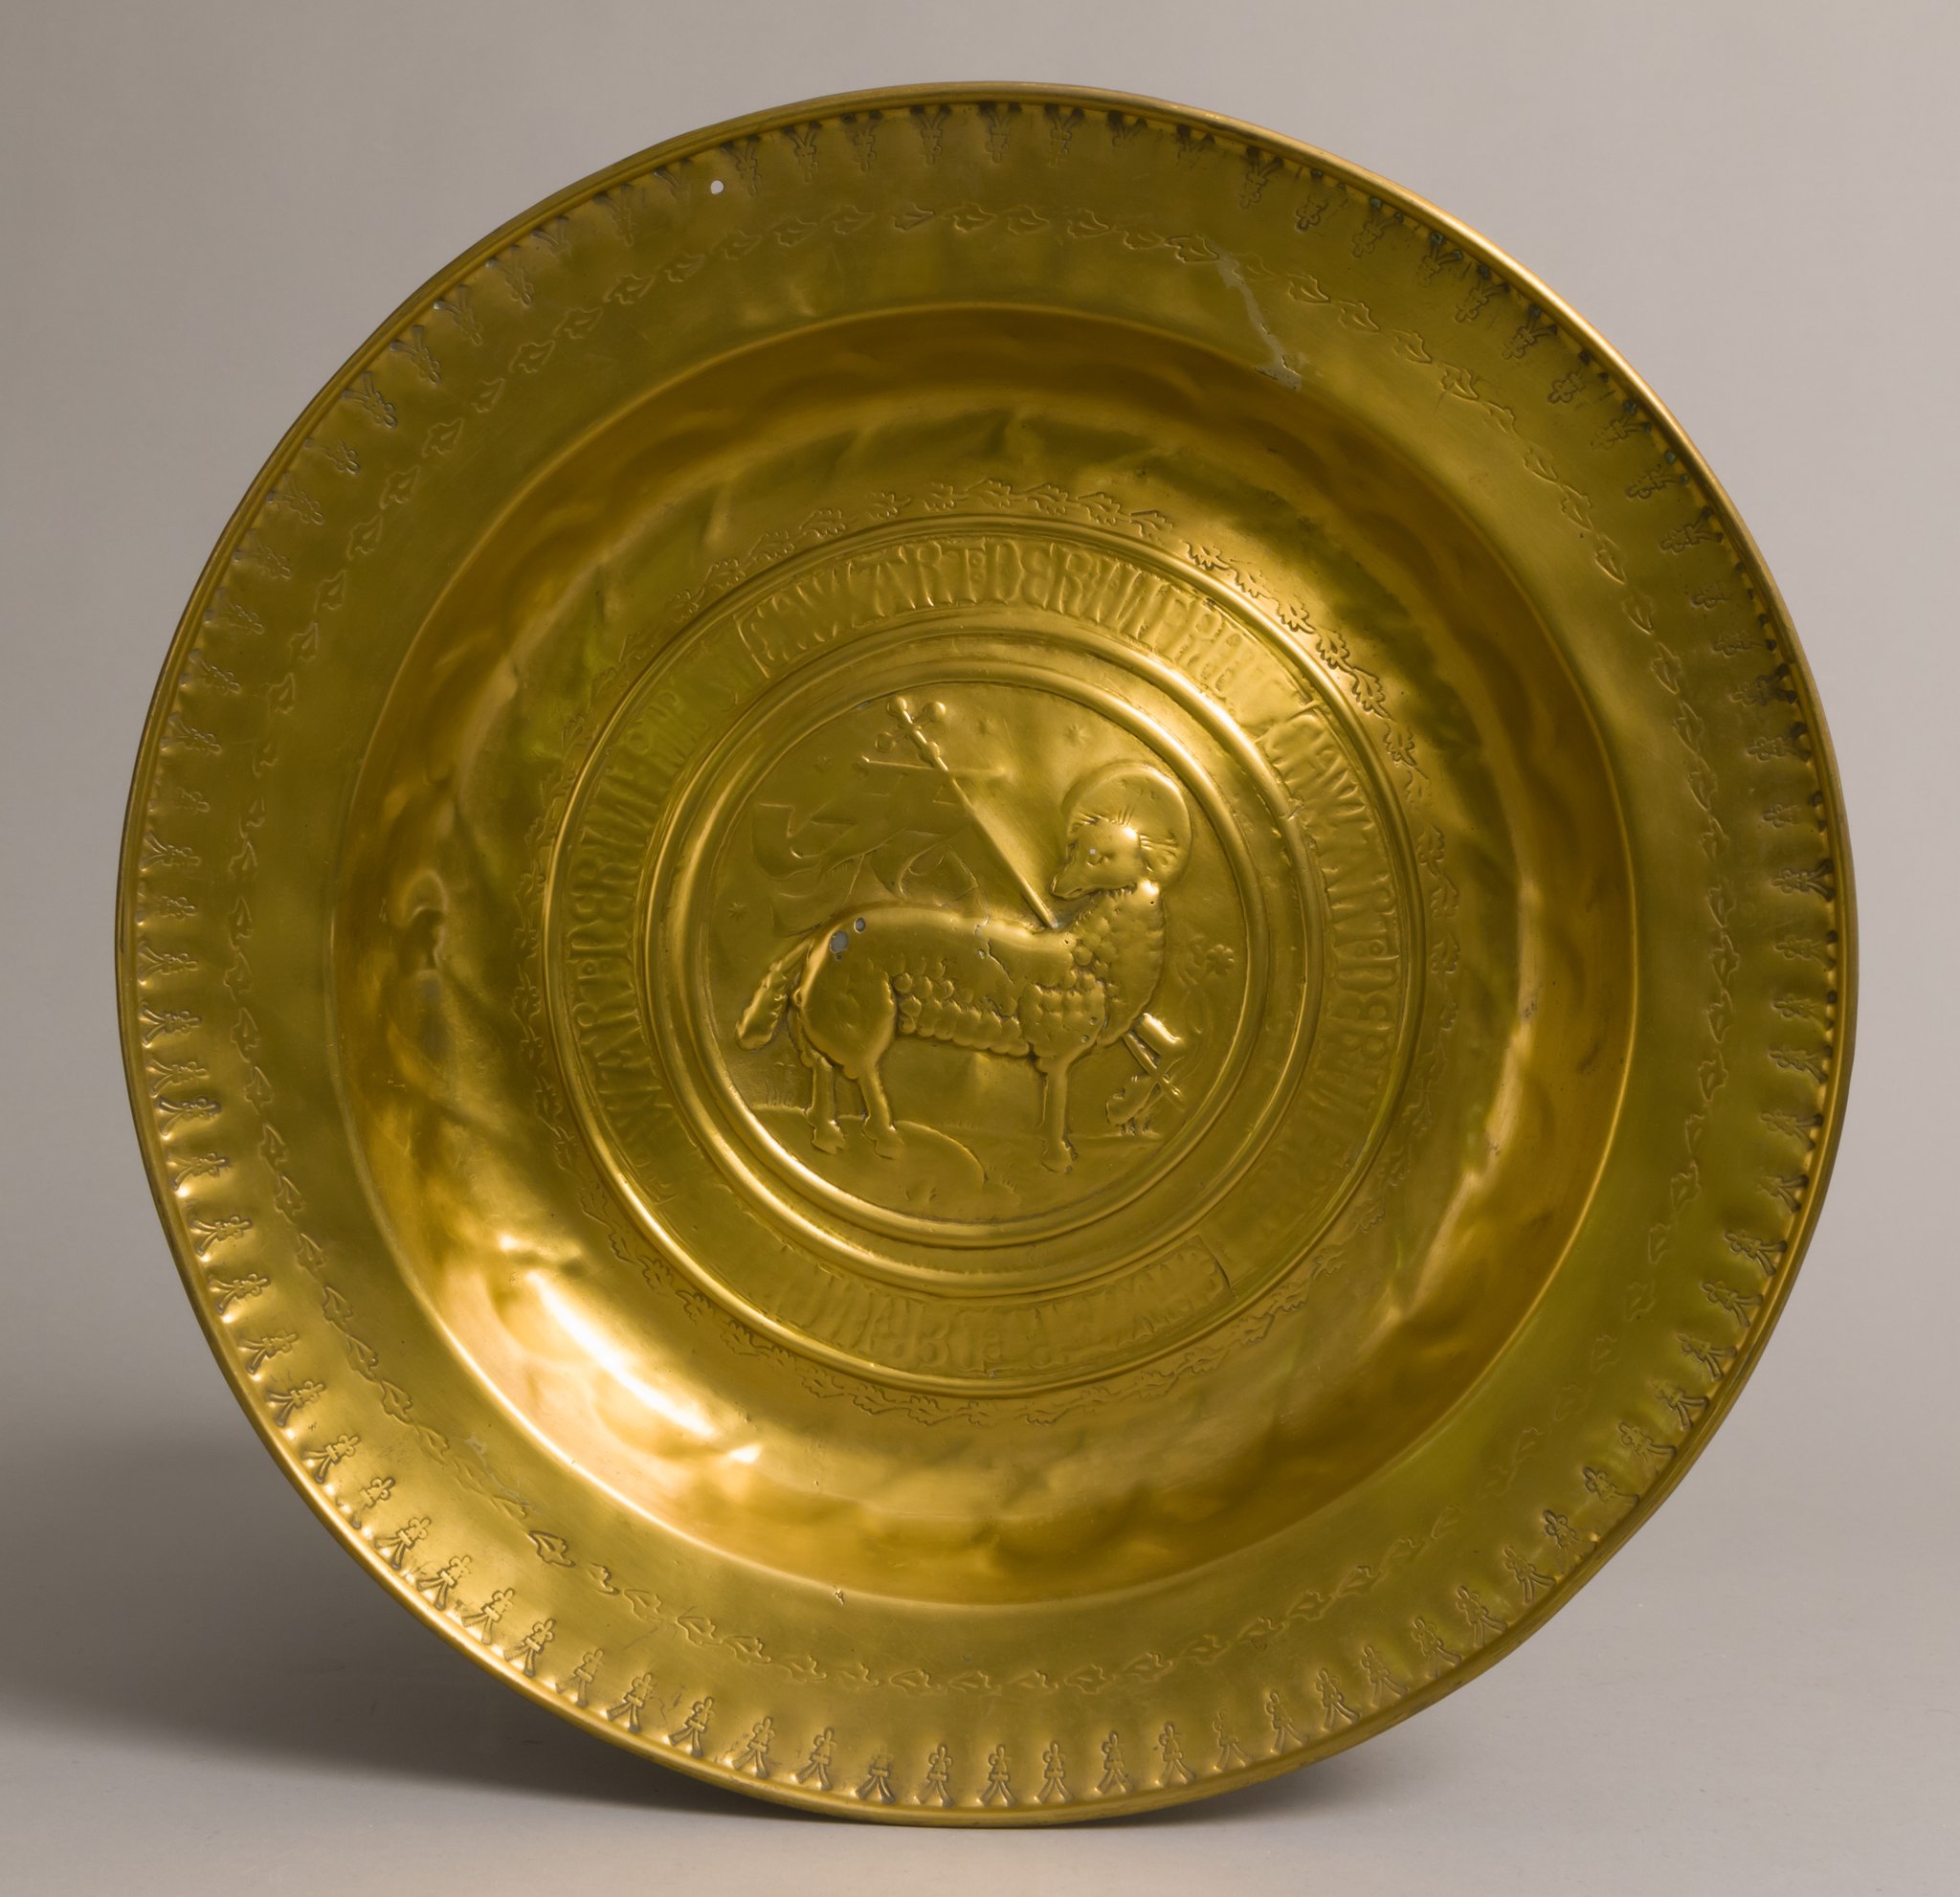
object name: dish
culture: german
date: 1501-1533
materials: brass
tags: lambs